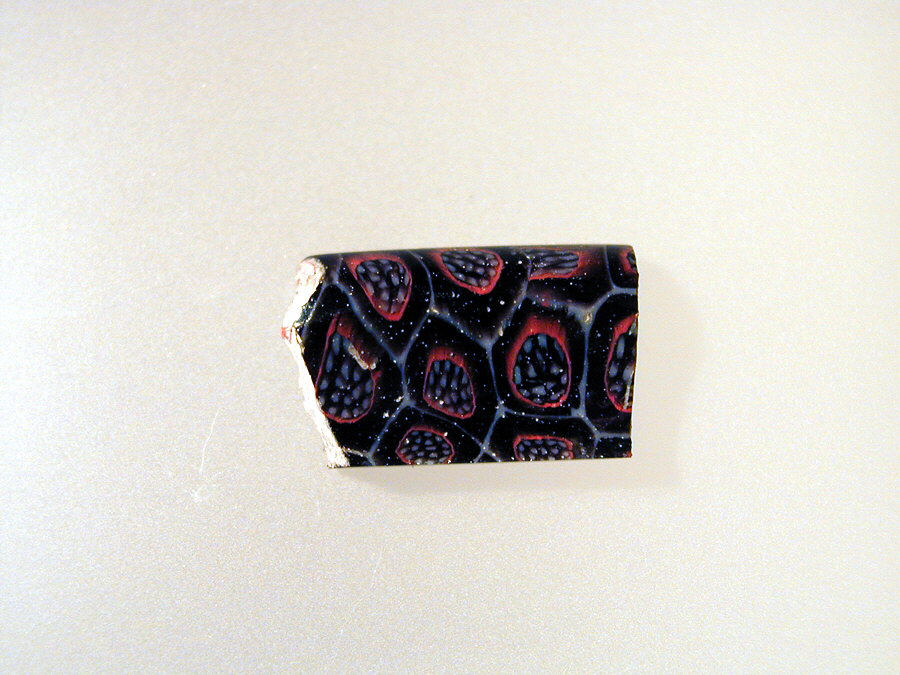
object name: fragment, mosaic bowl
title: Glass mosaic carinated bowl fragment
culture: roman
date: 34 BCE-33 CE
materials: glass